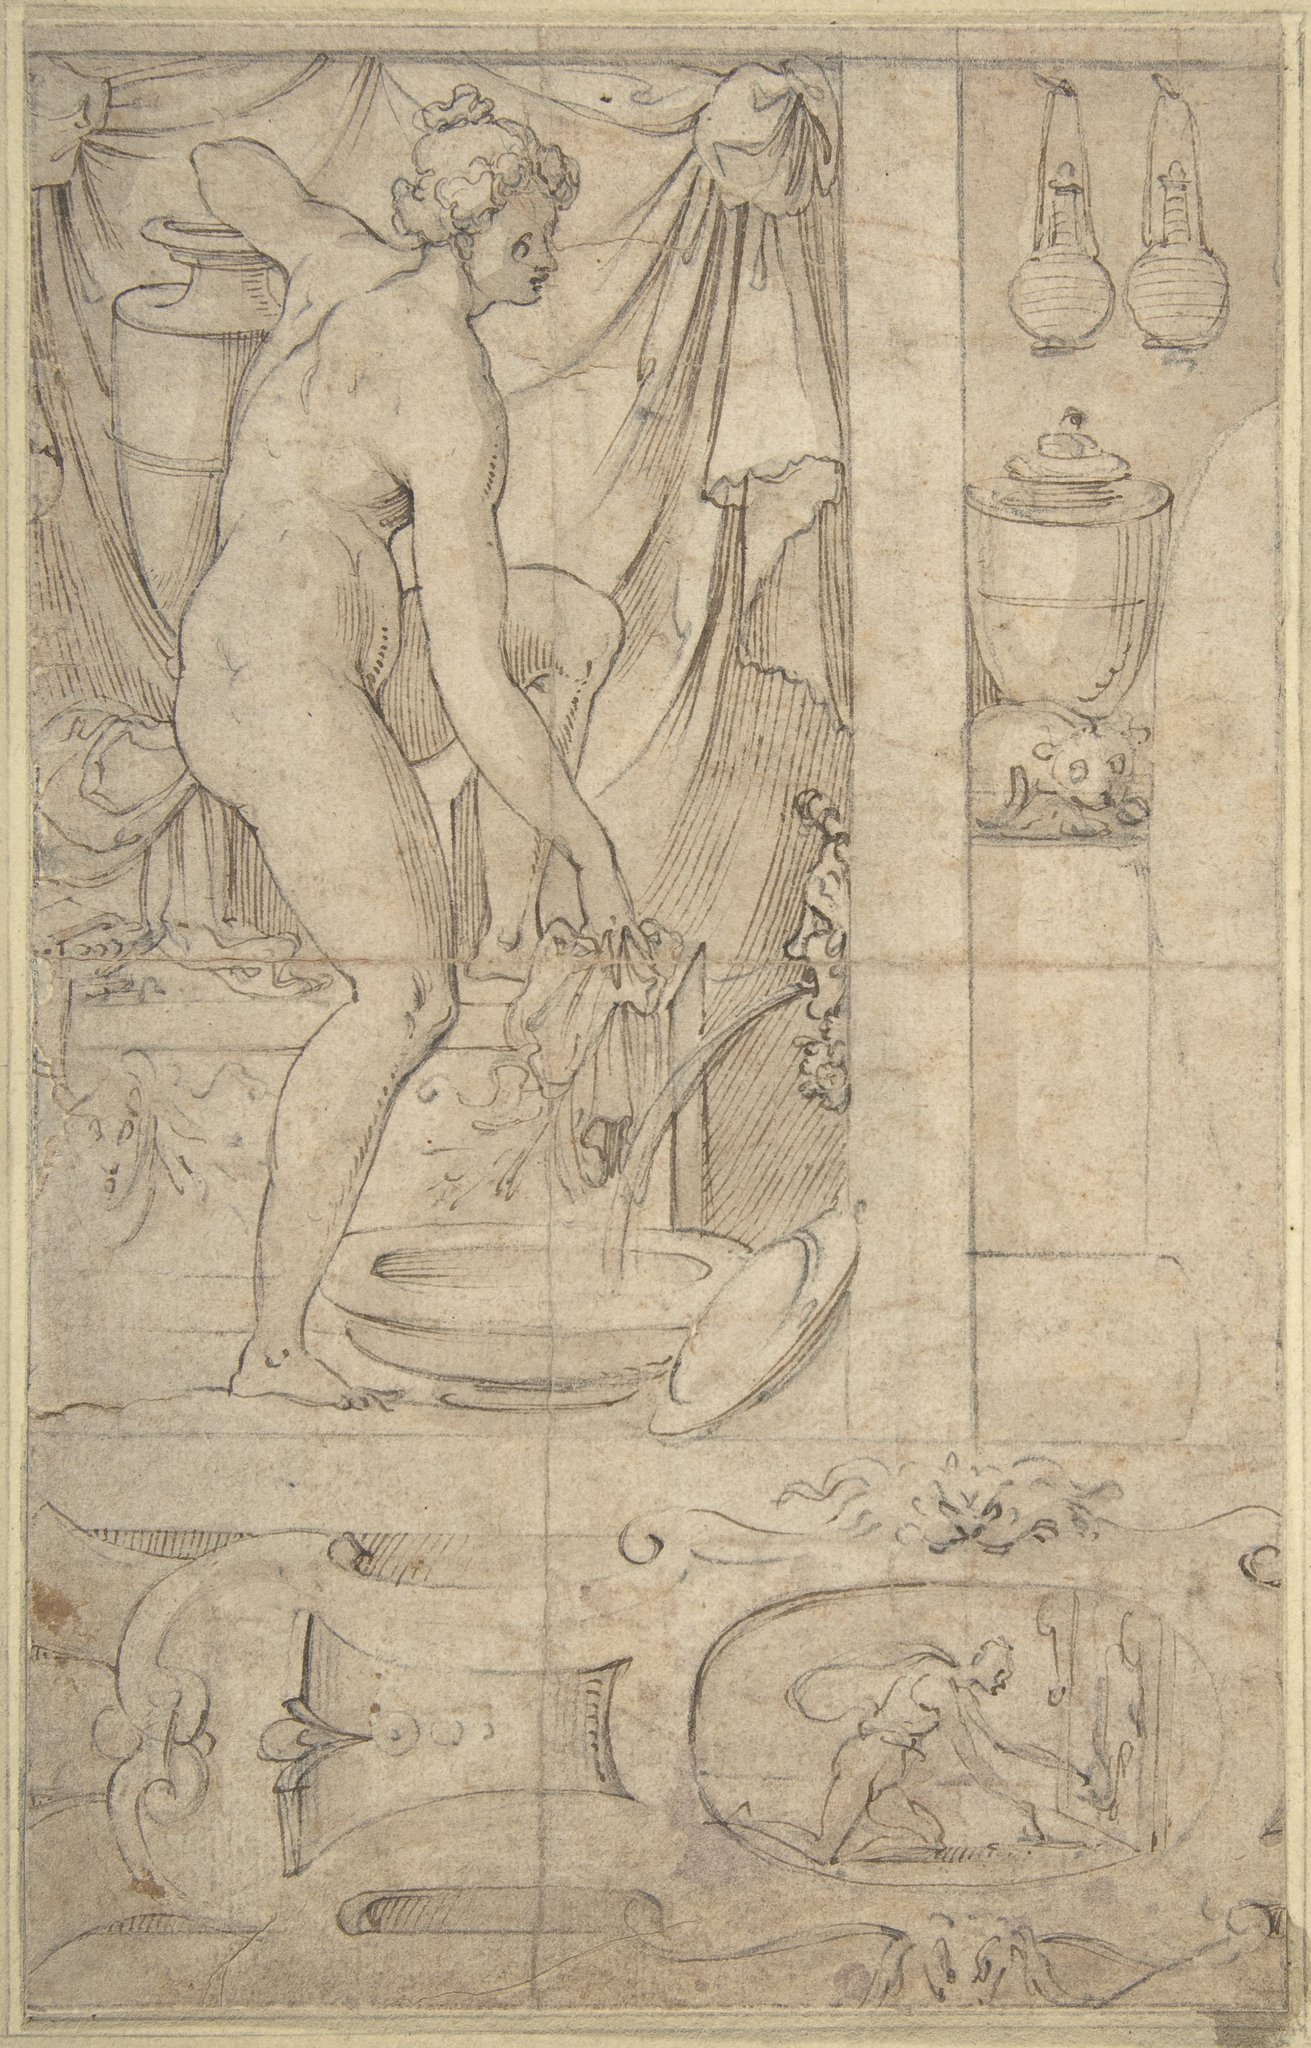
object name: drawing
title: Venus Bathing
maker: anonymous, french, school of fontainebleau, 16th century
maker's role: artist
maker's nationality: french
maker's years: 1500-1600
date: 1501-1600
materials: graphite, ink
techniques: pen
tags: venus,bathing